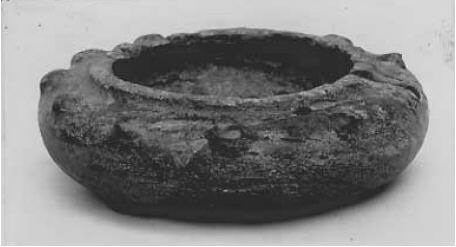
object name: bowl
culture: japanese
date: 601-700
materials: wood